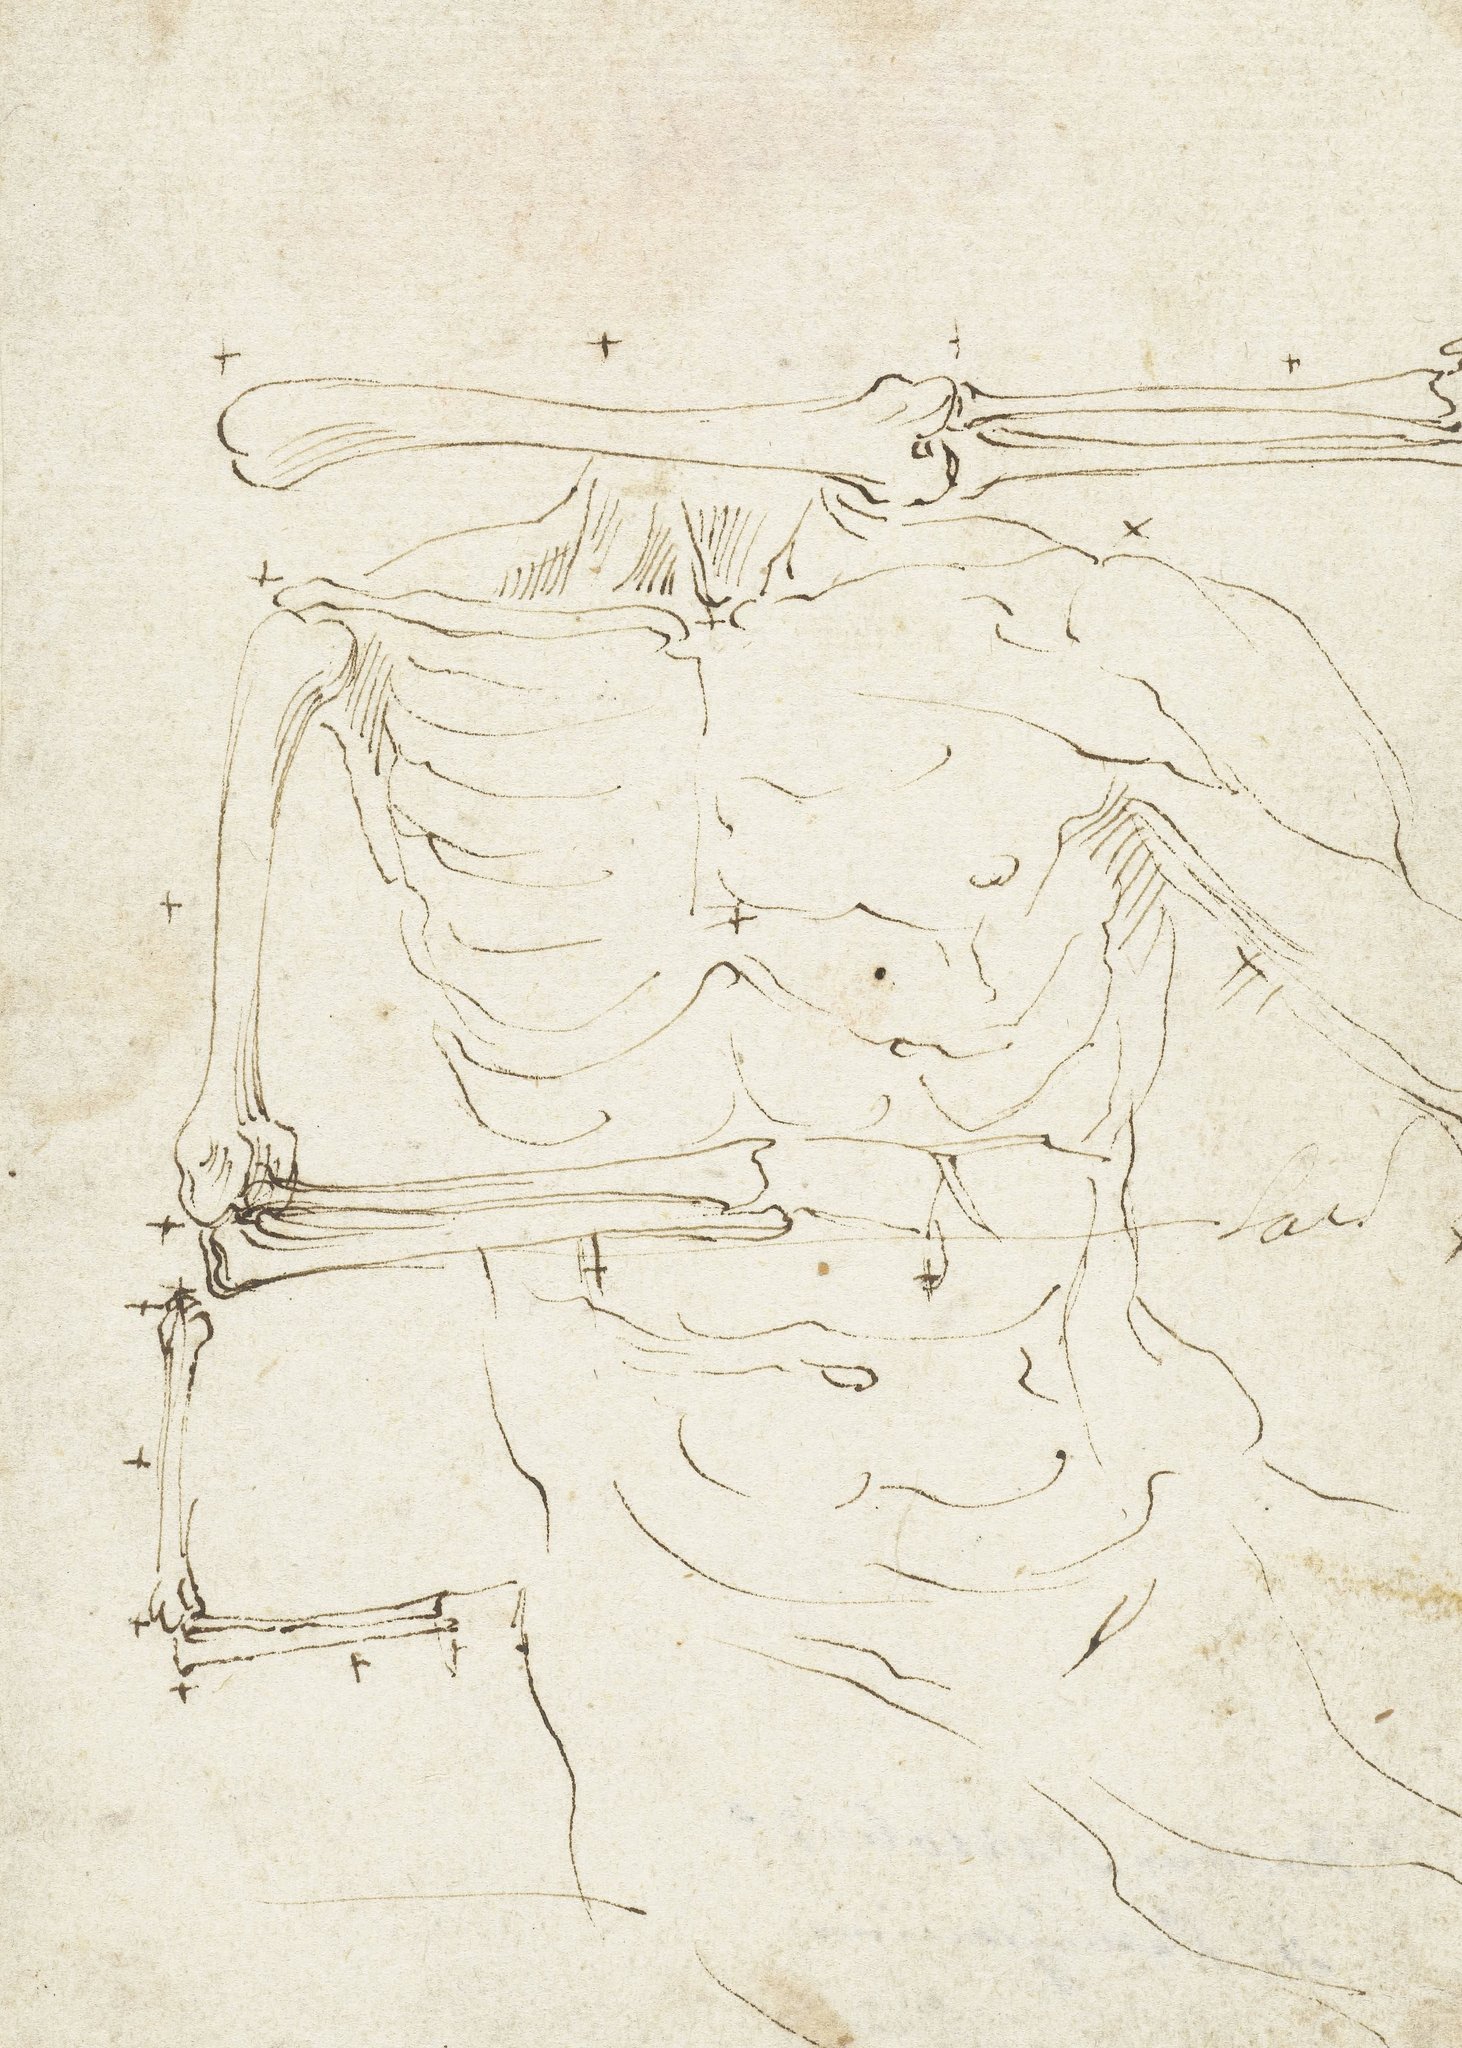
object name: drawing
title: Studie van een romp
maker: Anonymous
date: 1500-1599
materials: ink, paper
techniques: pen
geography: central italy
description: Studie van een romp, gedeeltelijk als skelet, gedeeltelijk met spieren bekleed.